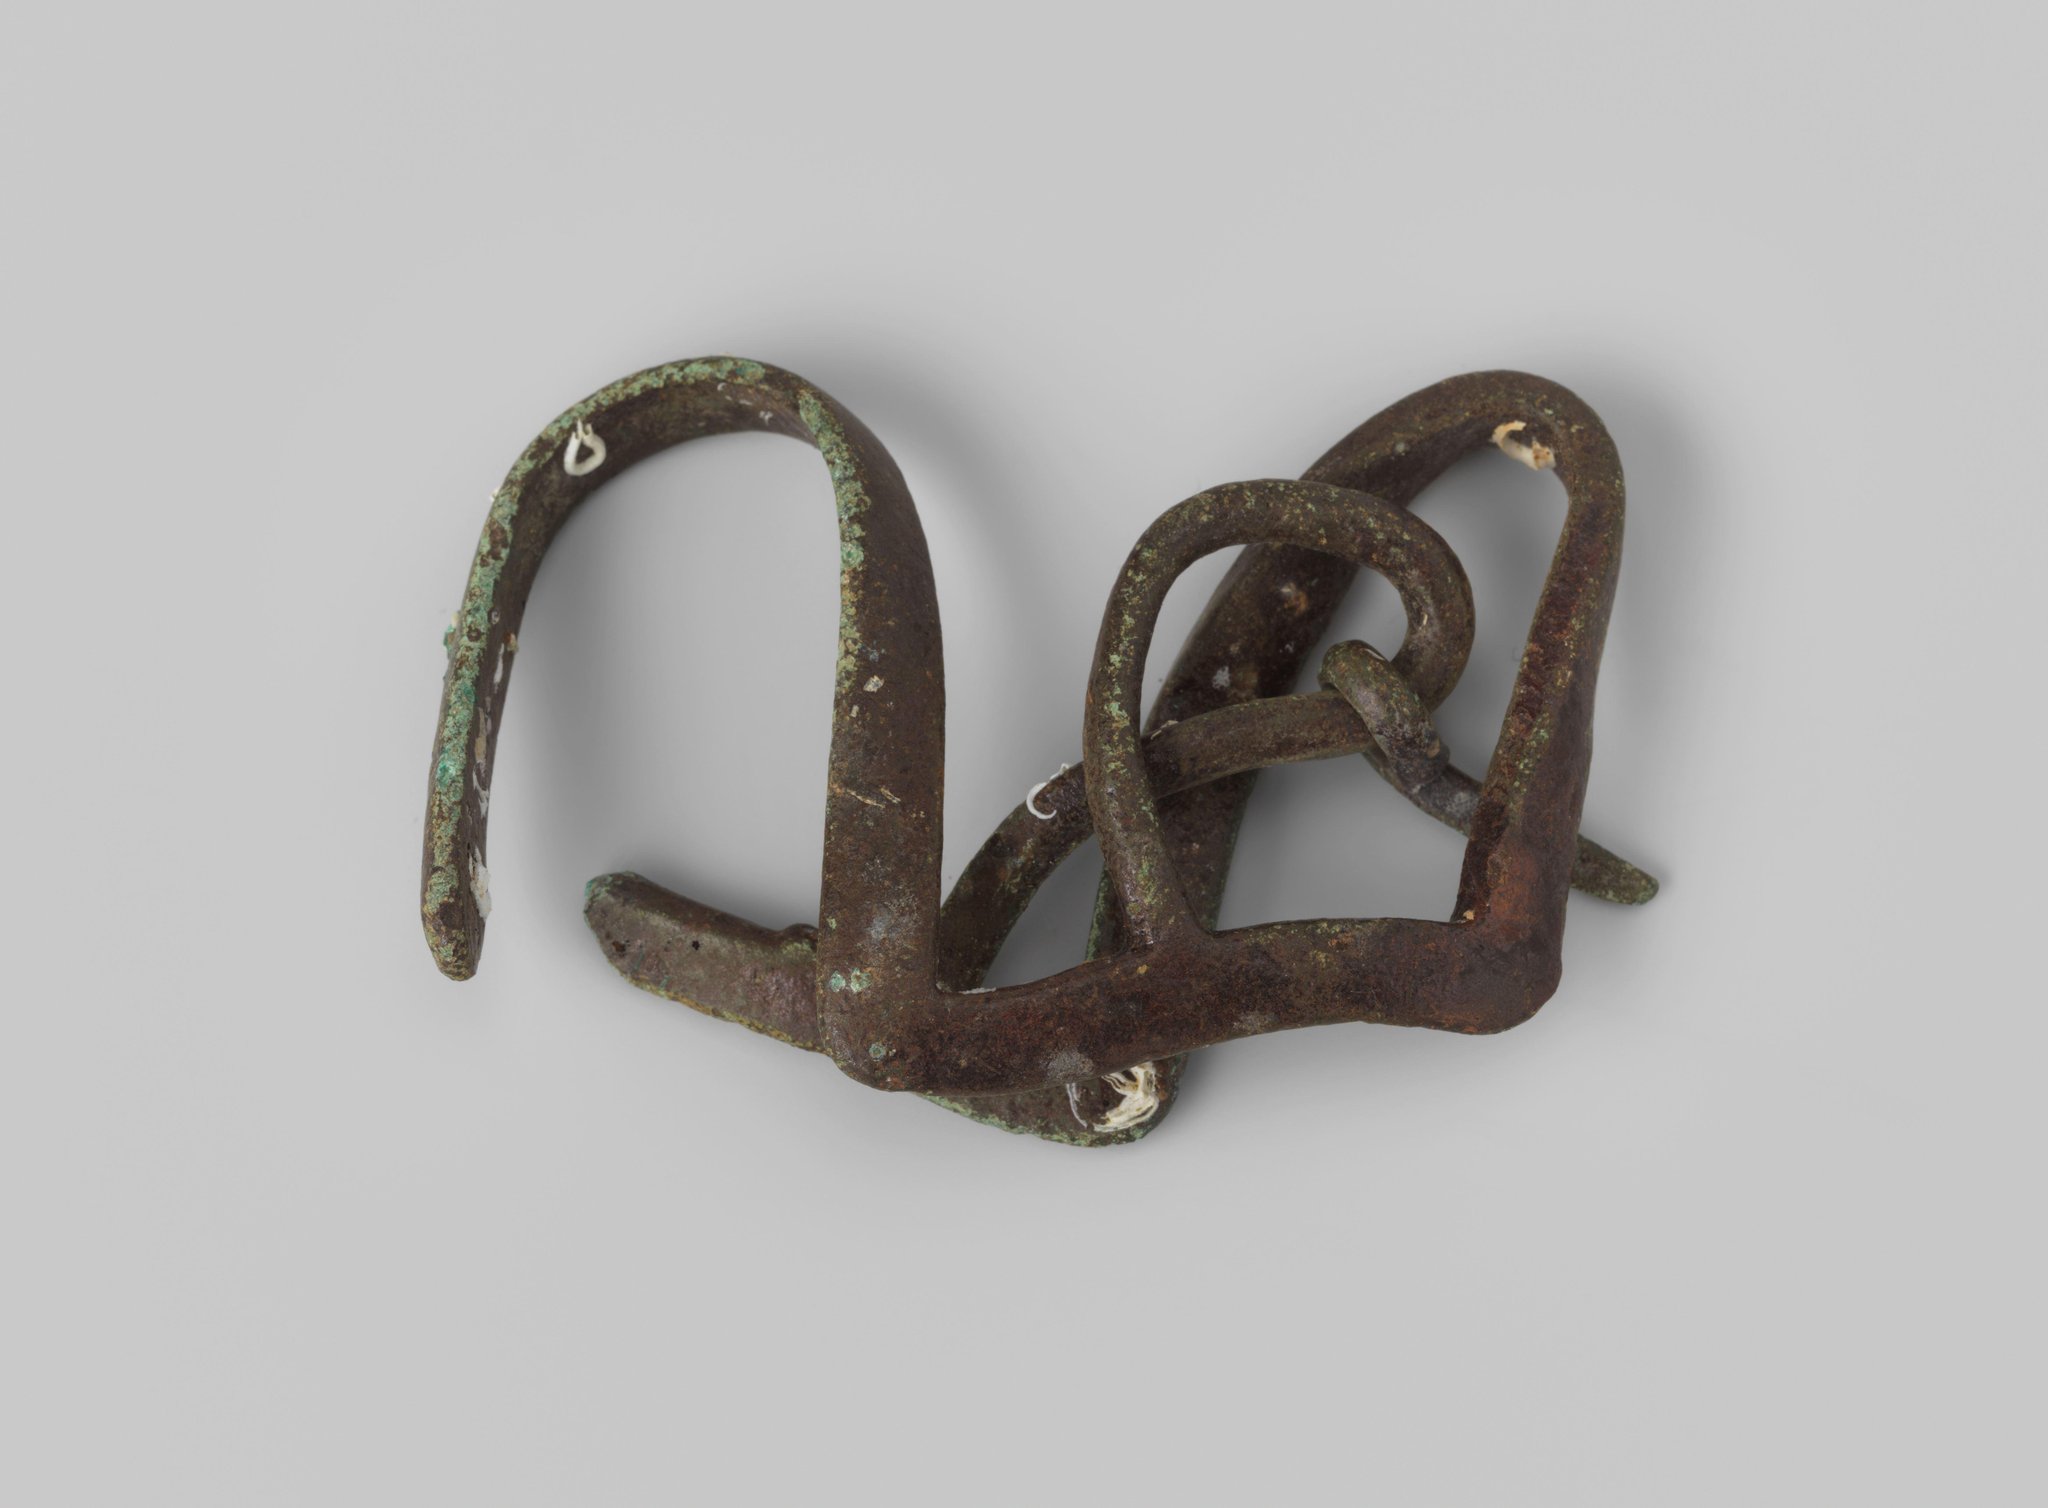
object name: belt buckle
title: Fragment riemgesp uit het wrak van de Oost-Indiëvaarder Hollandia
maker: Anonymous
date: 1700-1743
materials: copper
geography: netherlands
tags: verenigde oostindische compagnie, hollandia (schip), annet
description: Rectangular, ring with spindle and tongue, bent, id. NG 1980-27H2852, belt buckle.